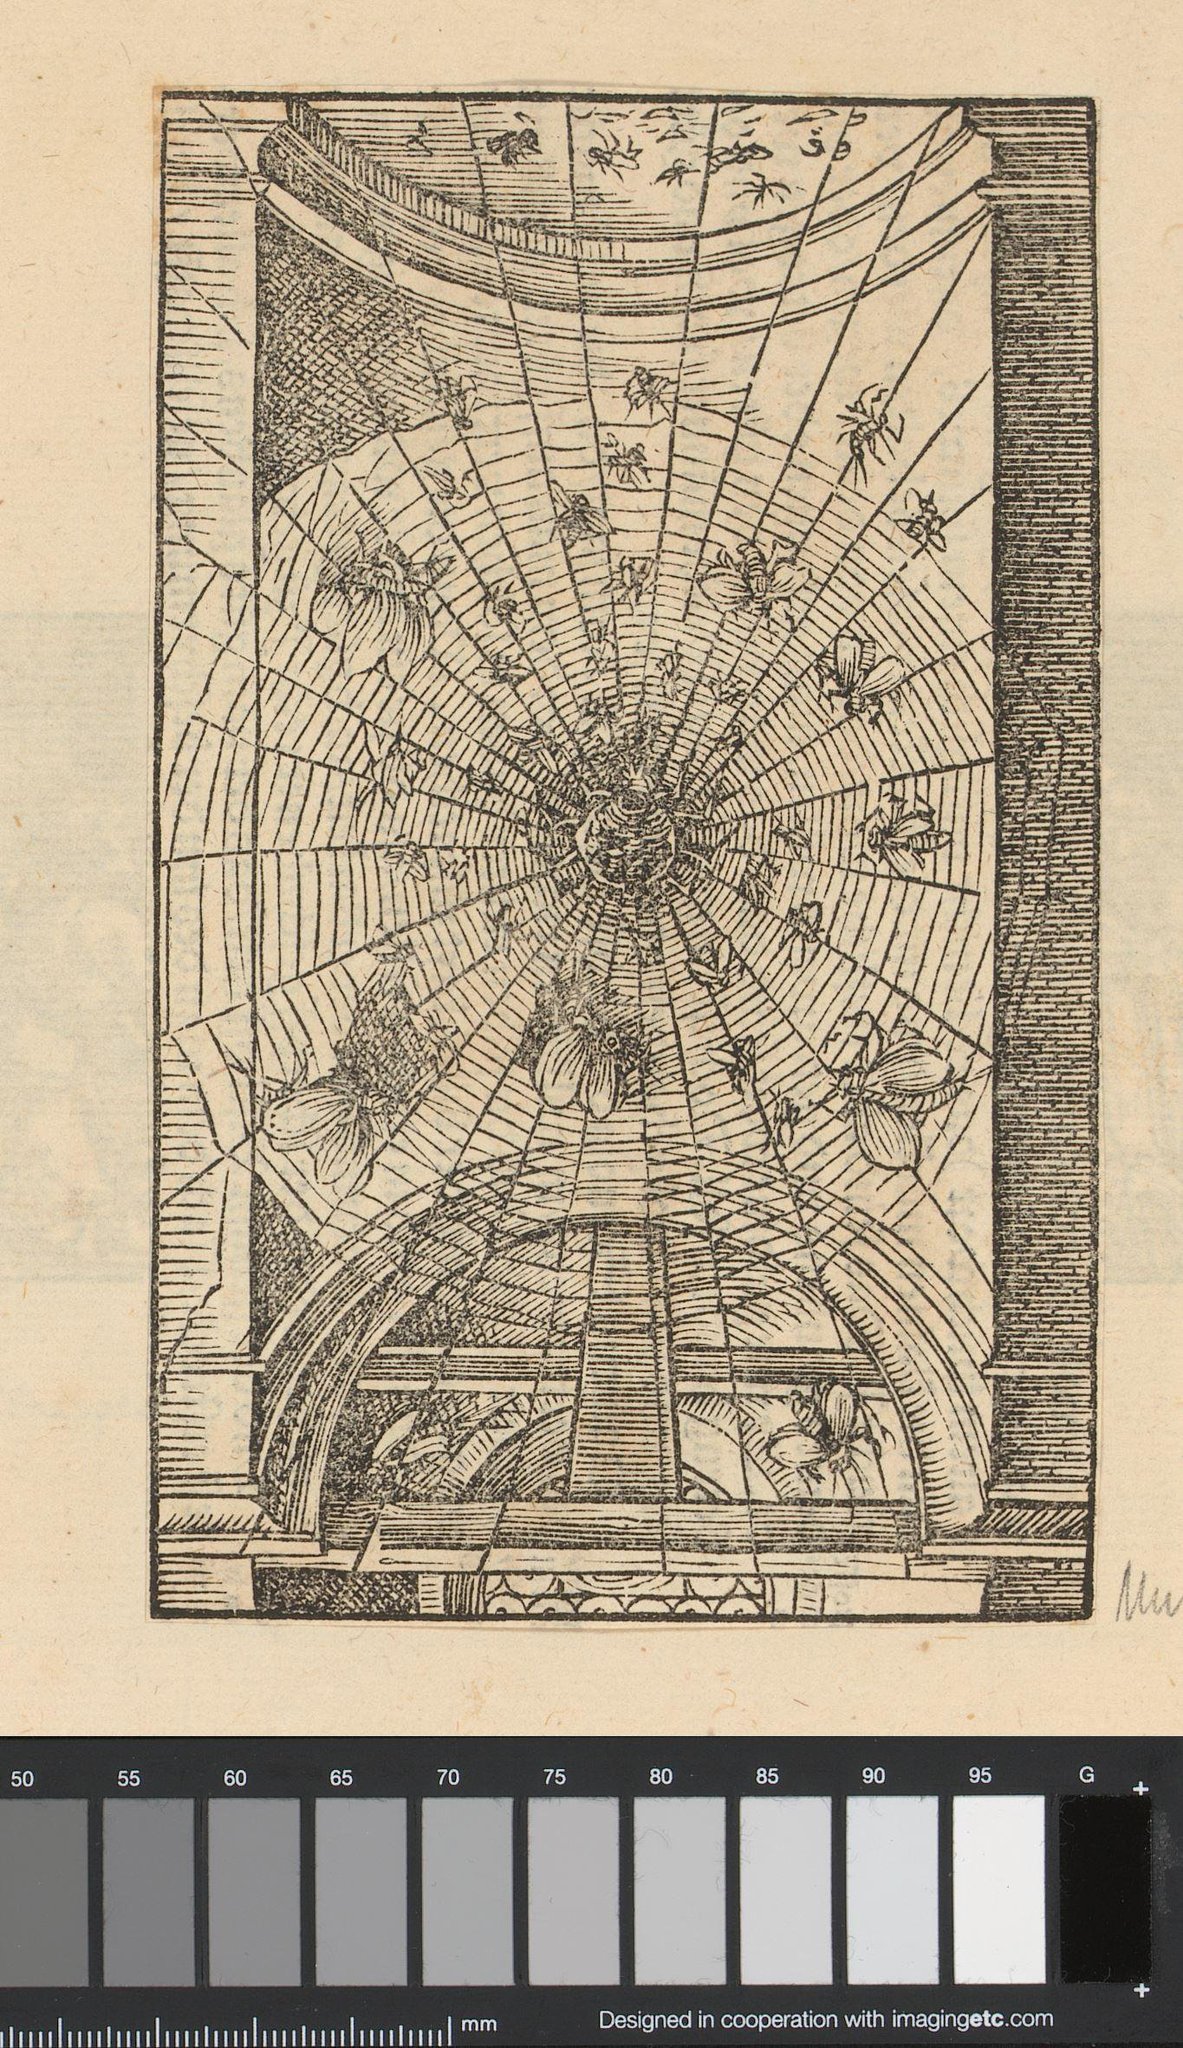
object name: album leaf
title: Gewelf met spinnenweb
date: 1514-1531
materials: paper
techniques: letterpress printing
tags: spiders, (decorated) ceiling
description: Deze prent is gebruikt in: Cicero, Marcus Tulius. Officia M.T.C. Ein Buch so Marcus Tullius Cicero der Römer zu seynem (...). [Vertaald uit het Latijn door] Johann von Schwarzenberg. Augsburg: Heinrich Steiner, 1531.